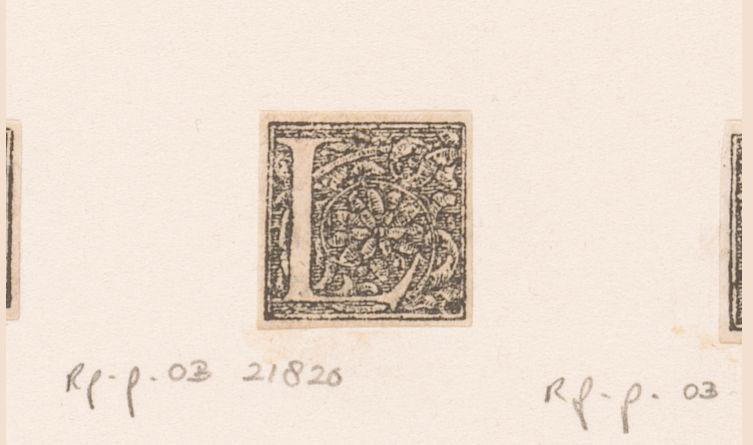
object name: print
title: Versierde initialen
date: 1500-1556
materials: paper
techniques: letterpress printing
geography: zurich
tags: initial, ornament derived from plant forms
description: Prent afkomstig uit: Bibel, die gantze, das ist alle Bücher alts und news Testaments (...). Zürich: Johann Froschauer, 1556.